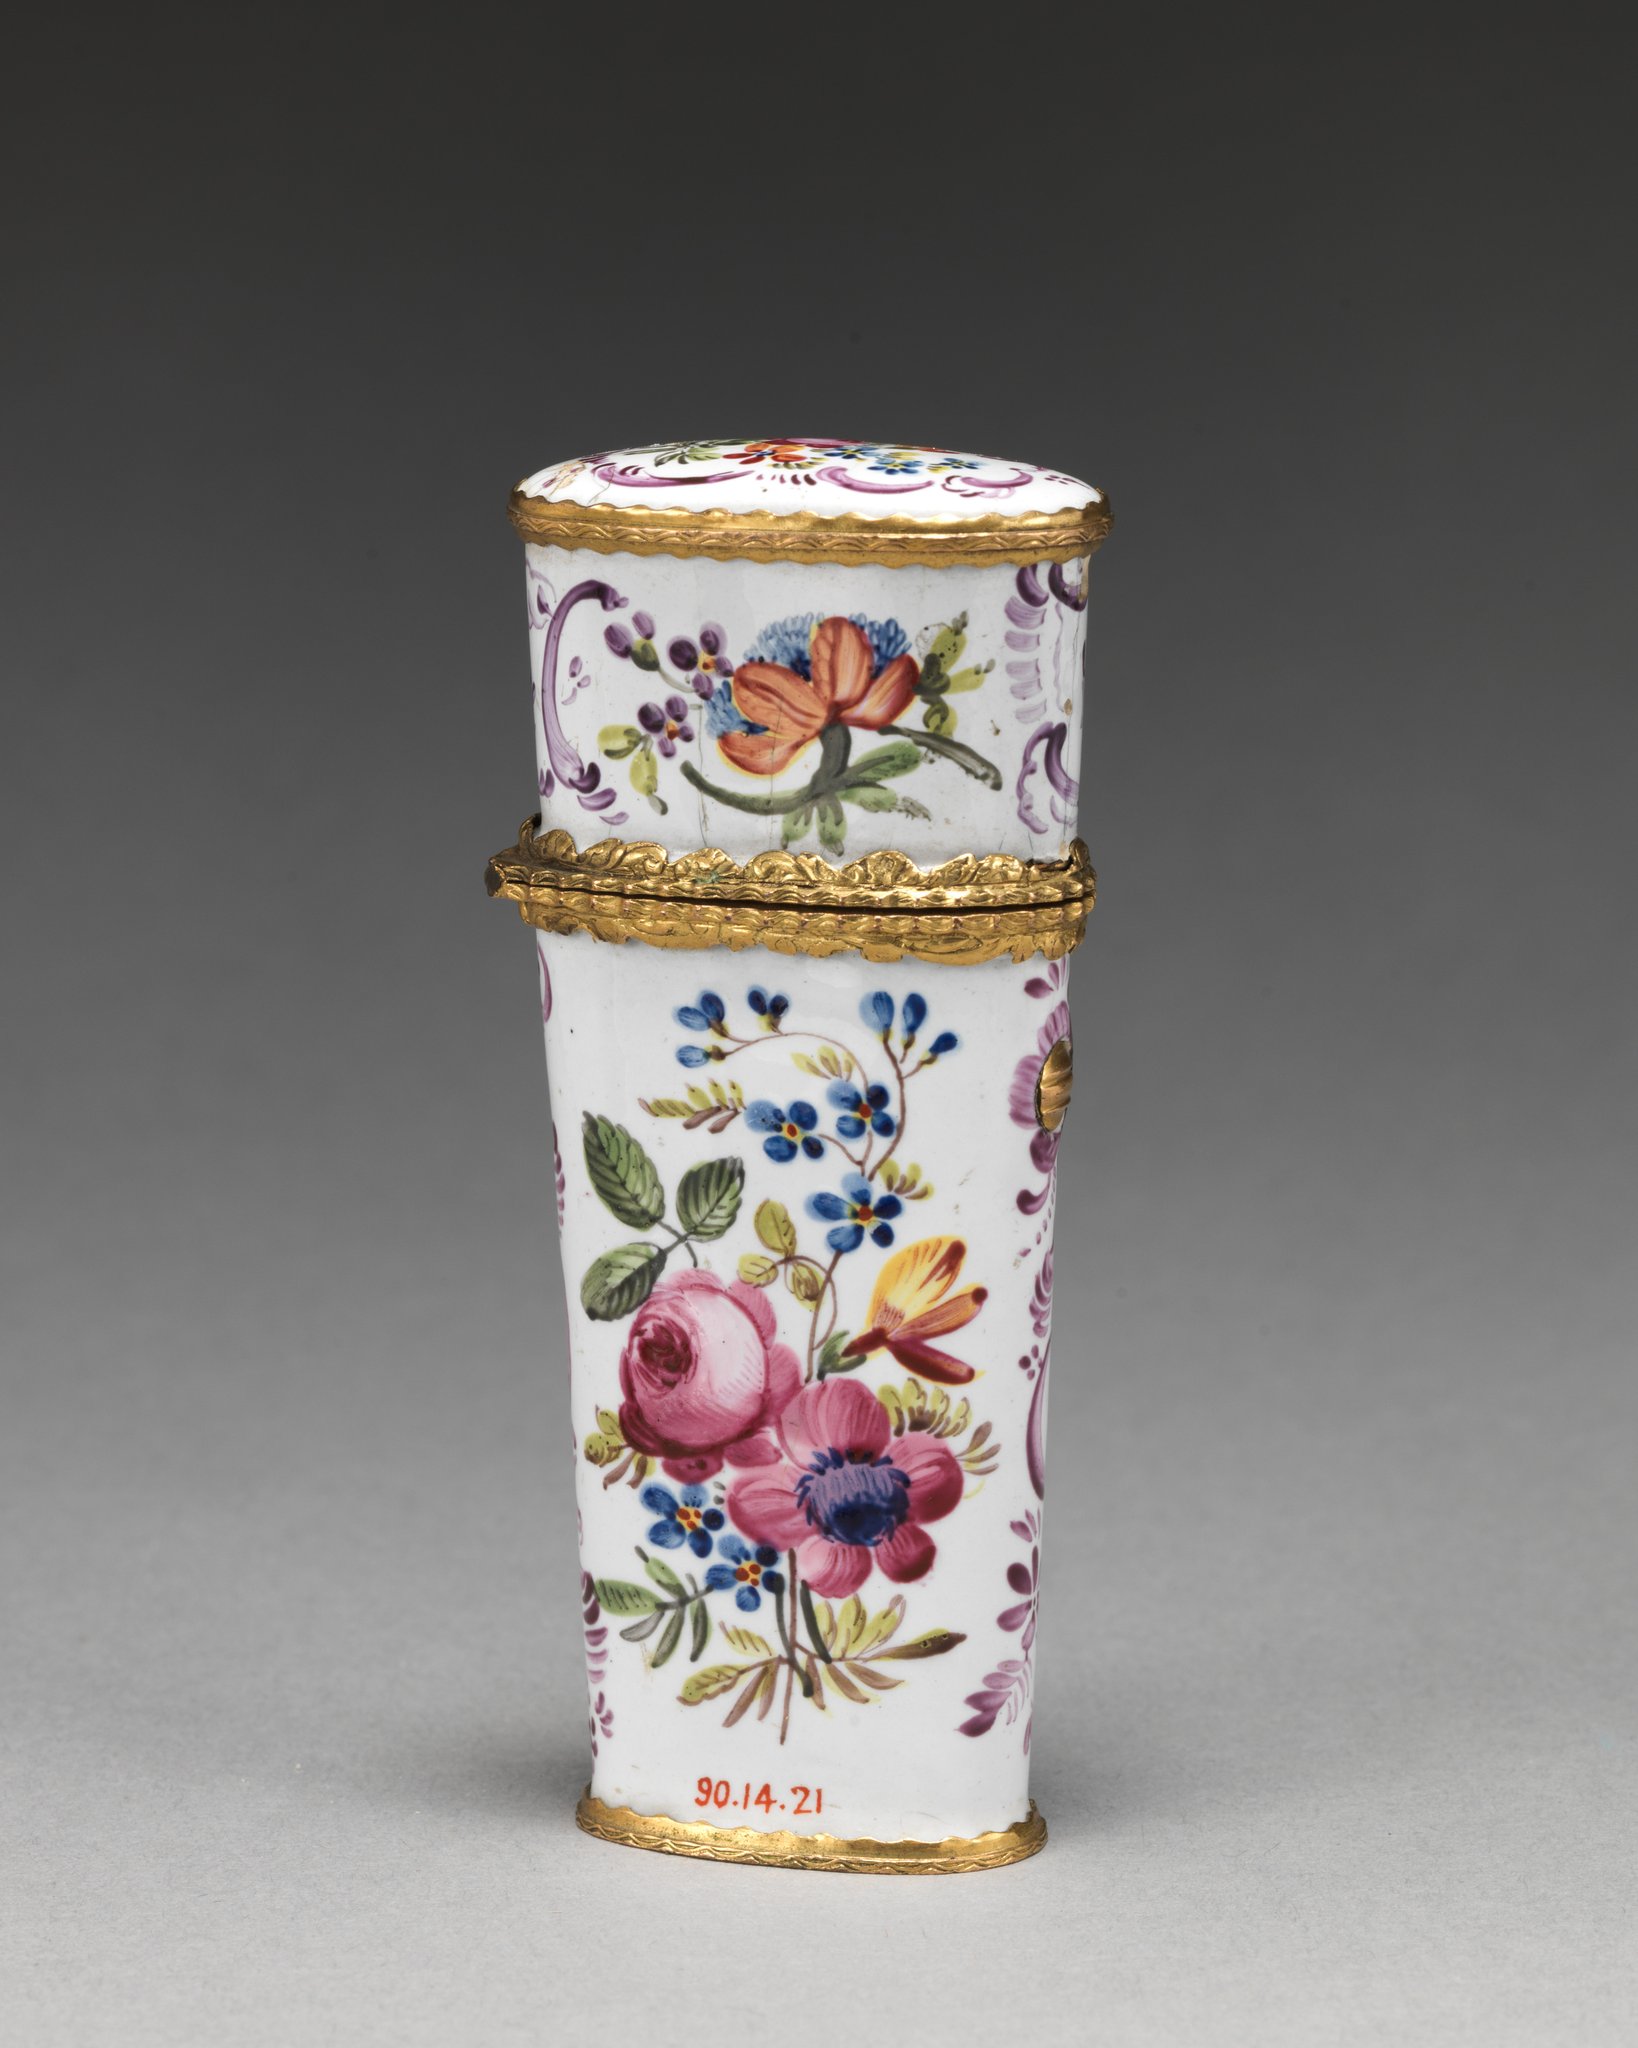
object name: étui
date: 1750-1760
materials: copper, enamel